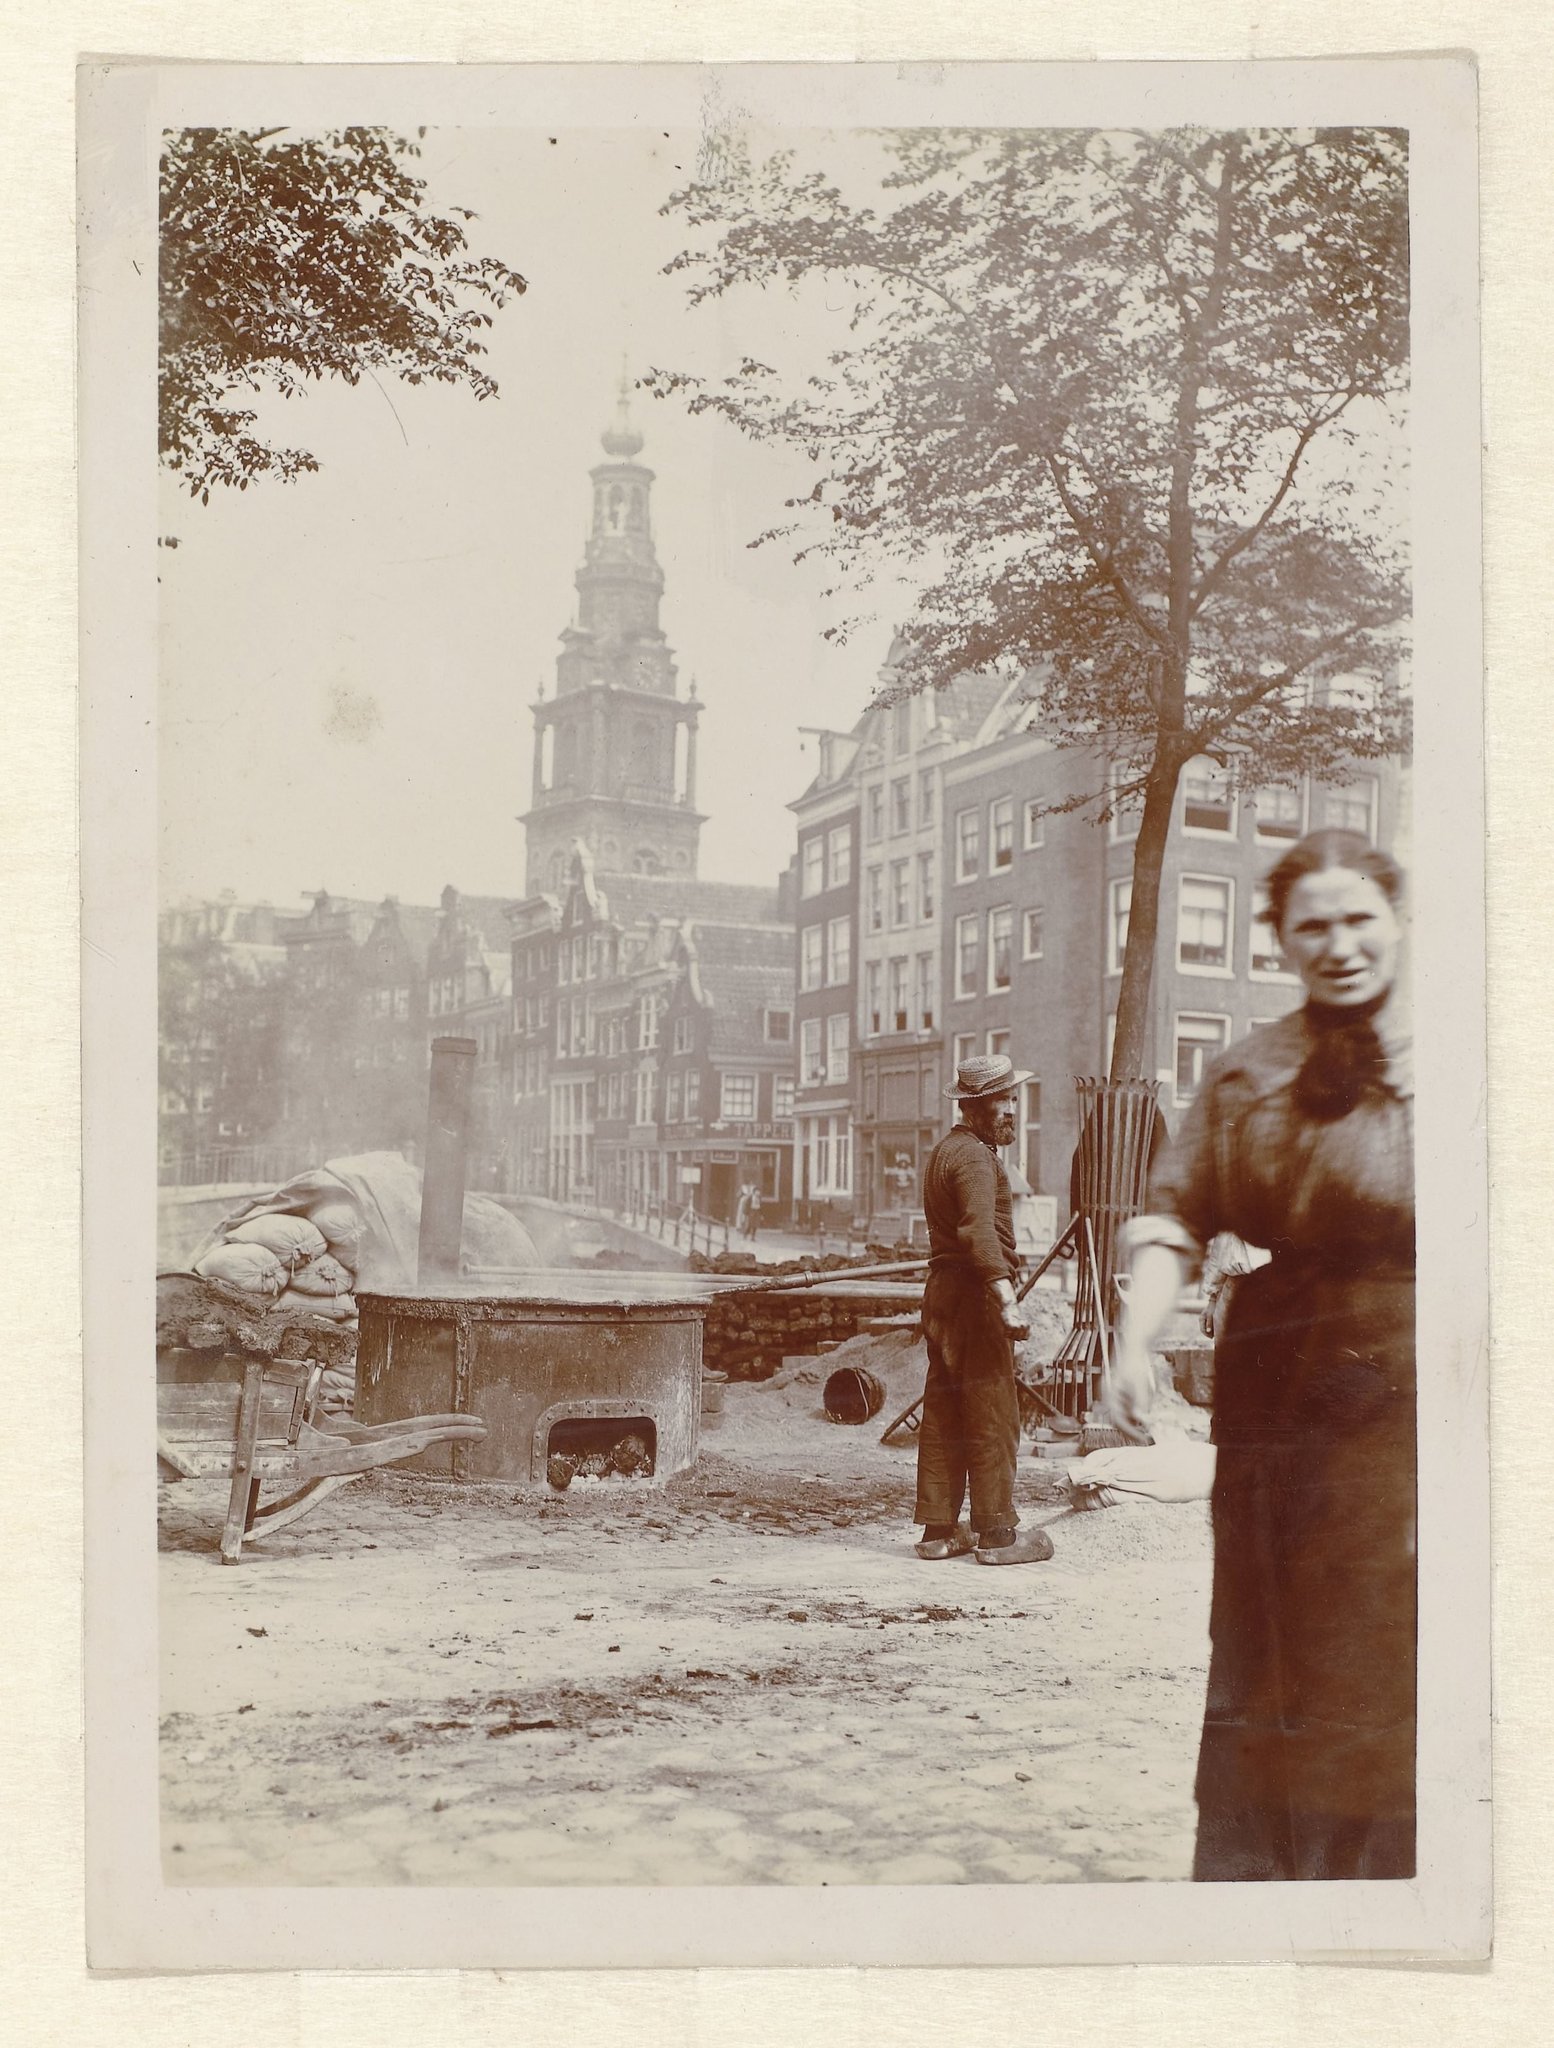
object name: photograph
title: Zuiderkerk in Amsterdam viewed from Zwanenburgwal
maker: james higson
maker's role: politician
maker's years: 1862-1933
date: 1904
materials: paper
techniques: gelatin silver print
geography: amsterdam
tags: street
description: Op de voorgrond huizen aan de Raamgracht, brug nr. 230 en de ingang naar de Moddermolensteeg.